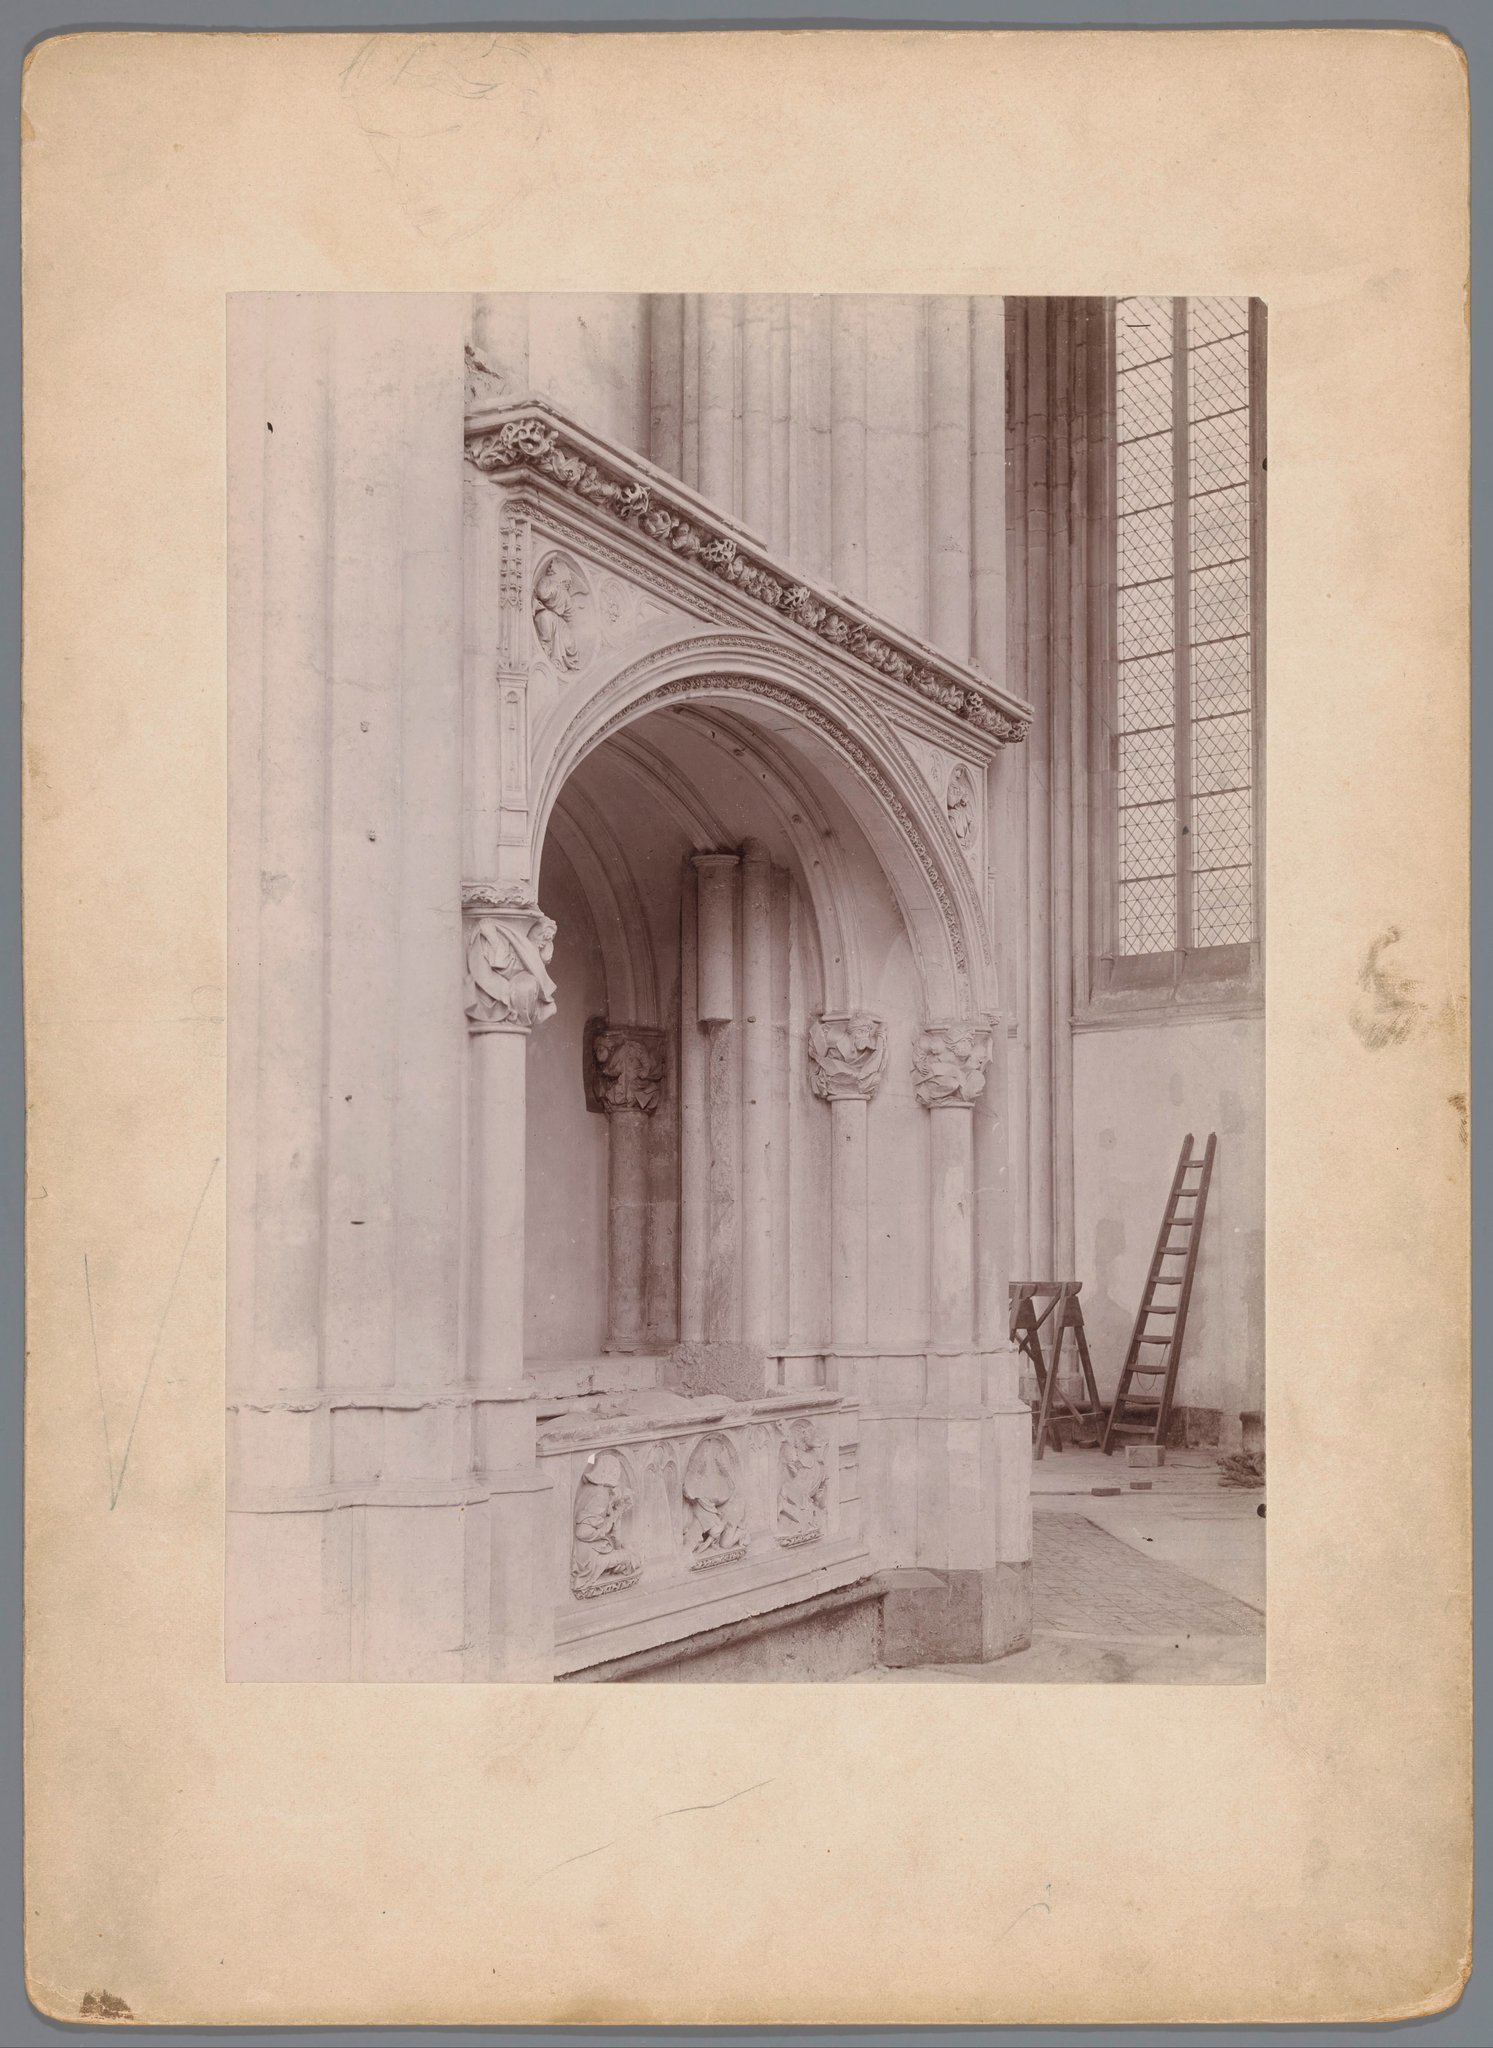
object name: photograph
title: Heilig Graf in de Dom van Utrecht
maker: Anonymous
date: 1875-1900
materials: cardboard, photographic support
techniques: daylight paper print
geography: utrecht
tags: parts of church interior, grave-building, monumental tomb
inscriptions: annotation:, inscription: ‘Utrecht R K kerk Grafmonument’, collector's mark: Lugt 3937